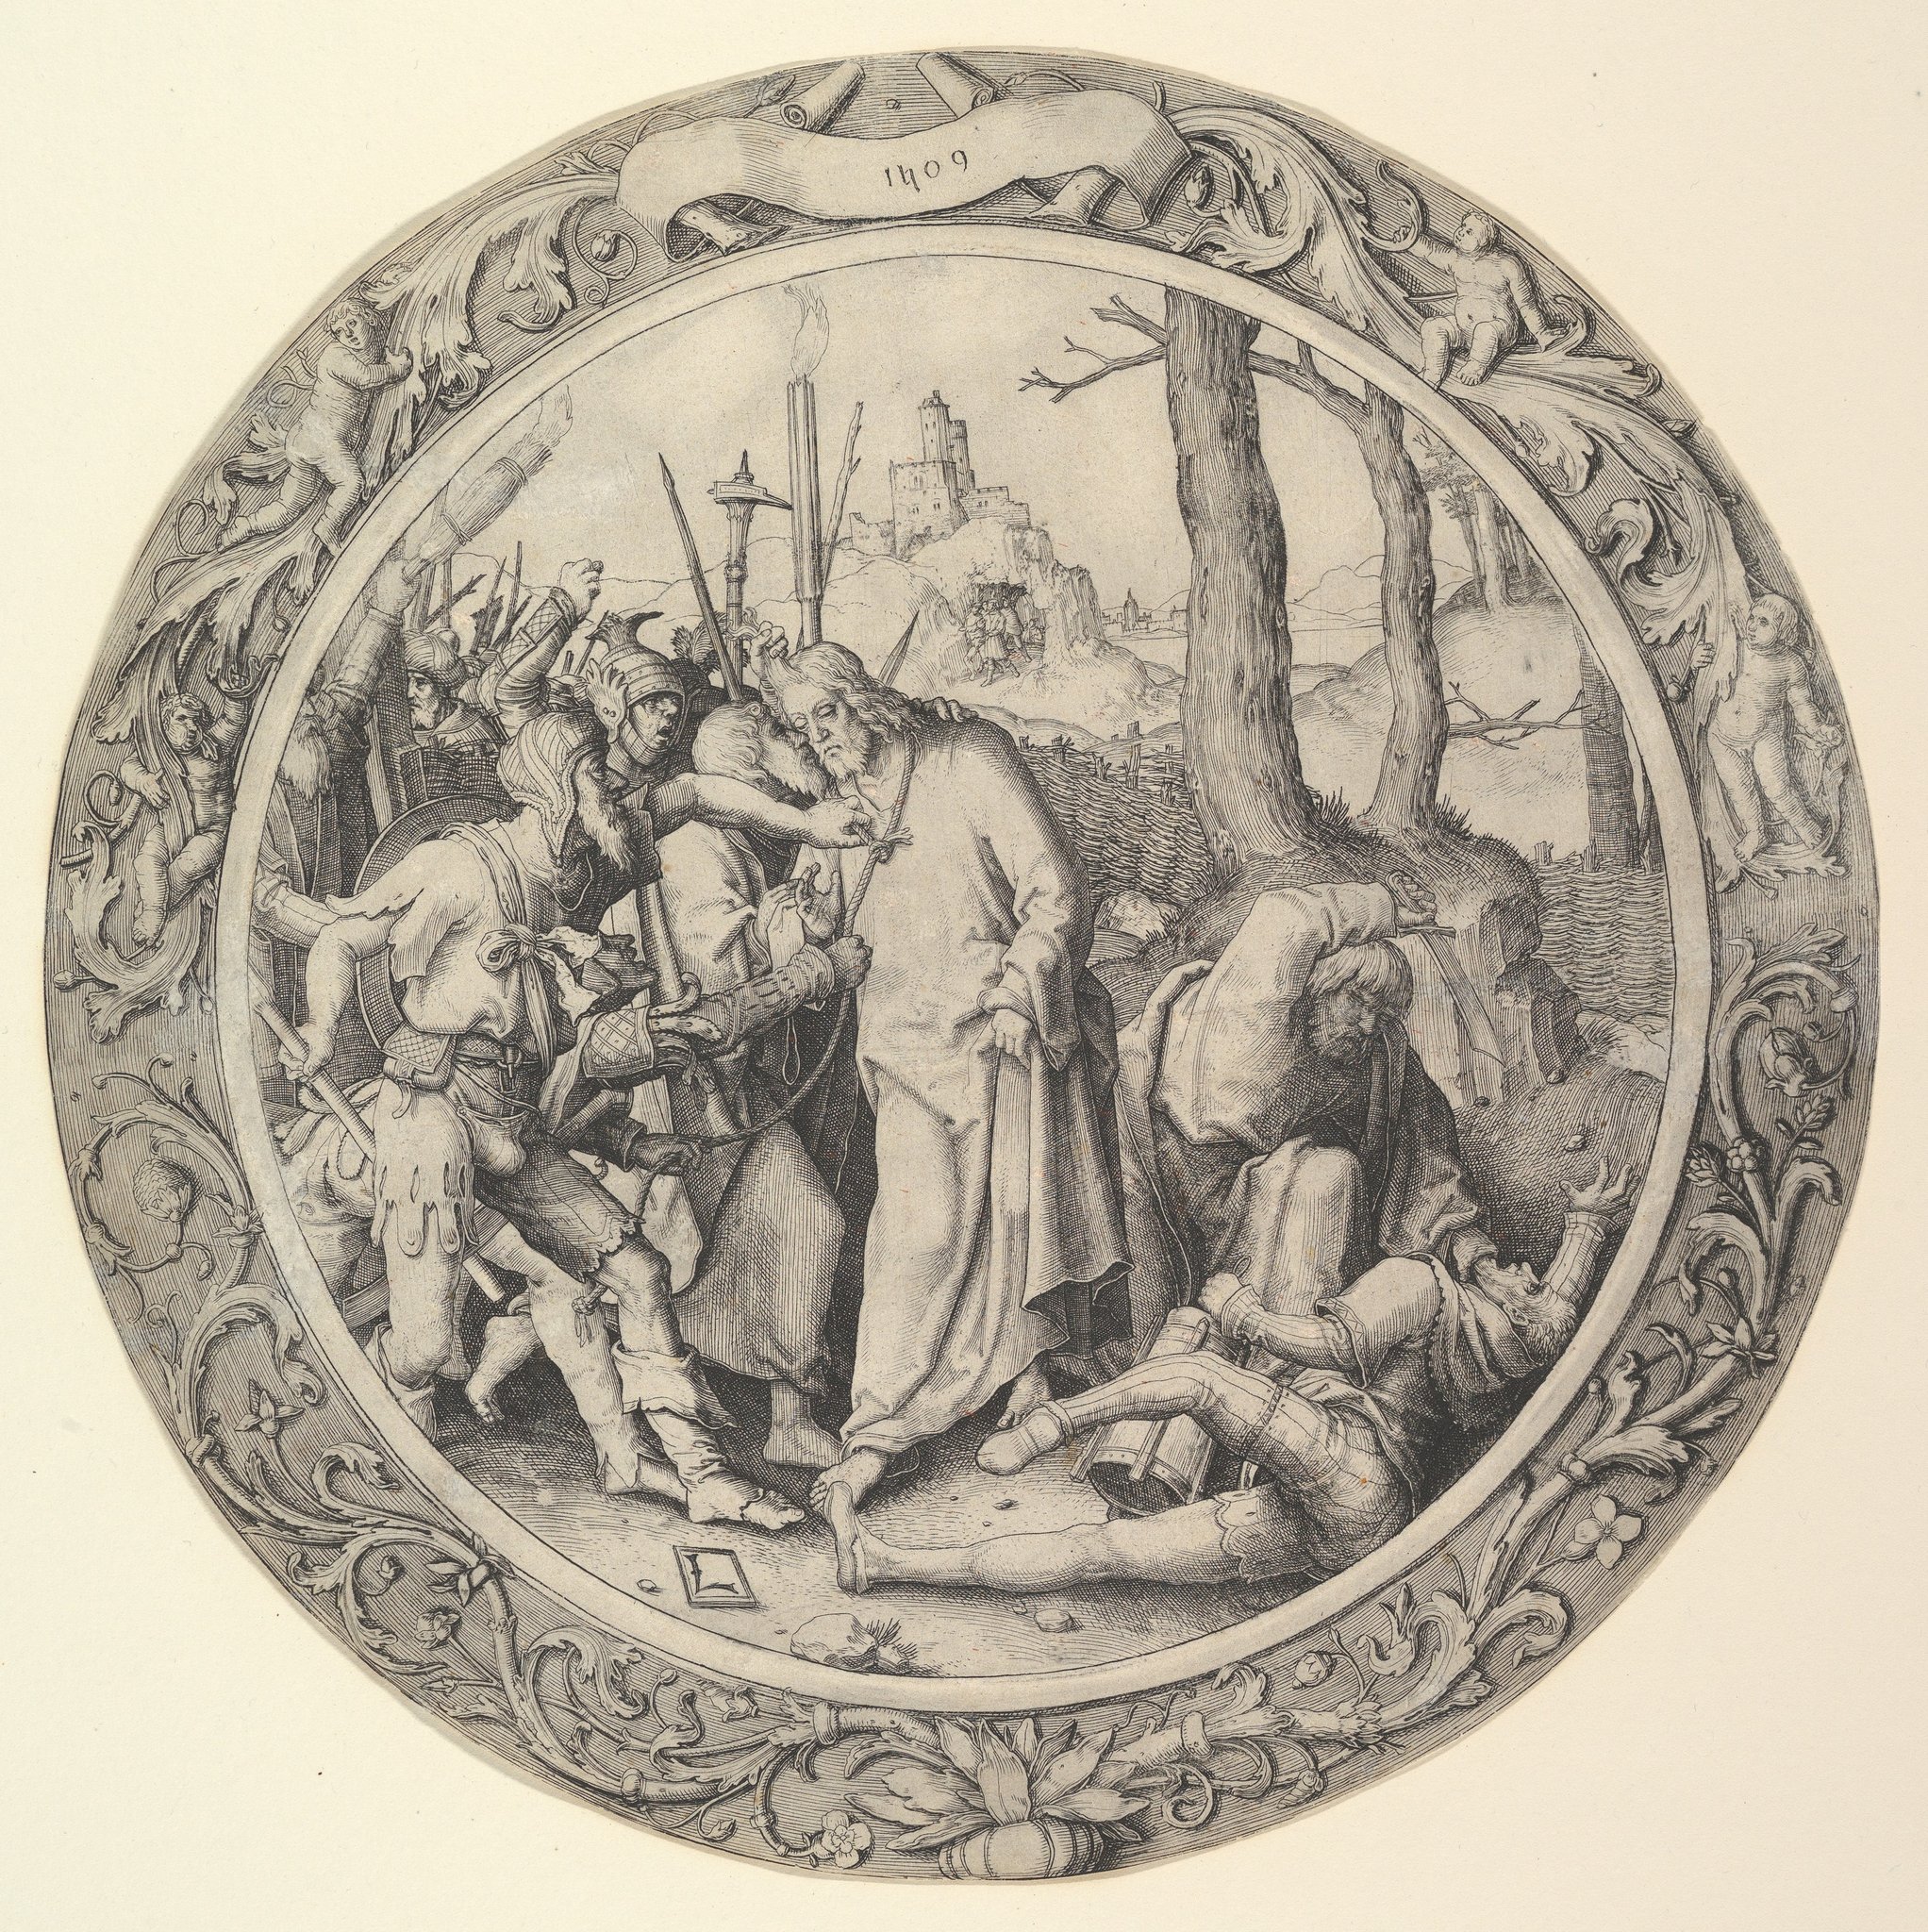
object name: print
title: The Betrayal of Christ, (Christ Taken Captive), from the Circular Passion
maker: lucas van leyden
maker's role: artist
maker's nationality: netherlandish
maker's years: 1494-1533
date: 1509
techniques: engraving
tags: soldiers,weapons,christ